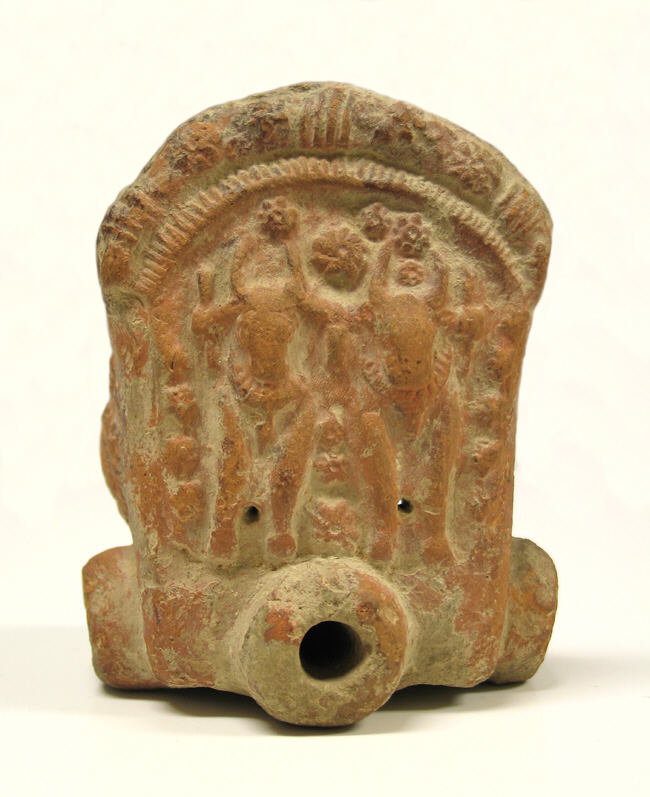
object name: cart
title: Toy Model of a Cart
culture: indian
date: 100 BCE-100 CE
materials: terracotta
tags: shunga,bulls,toys